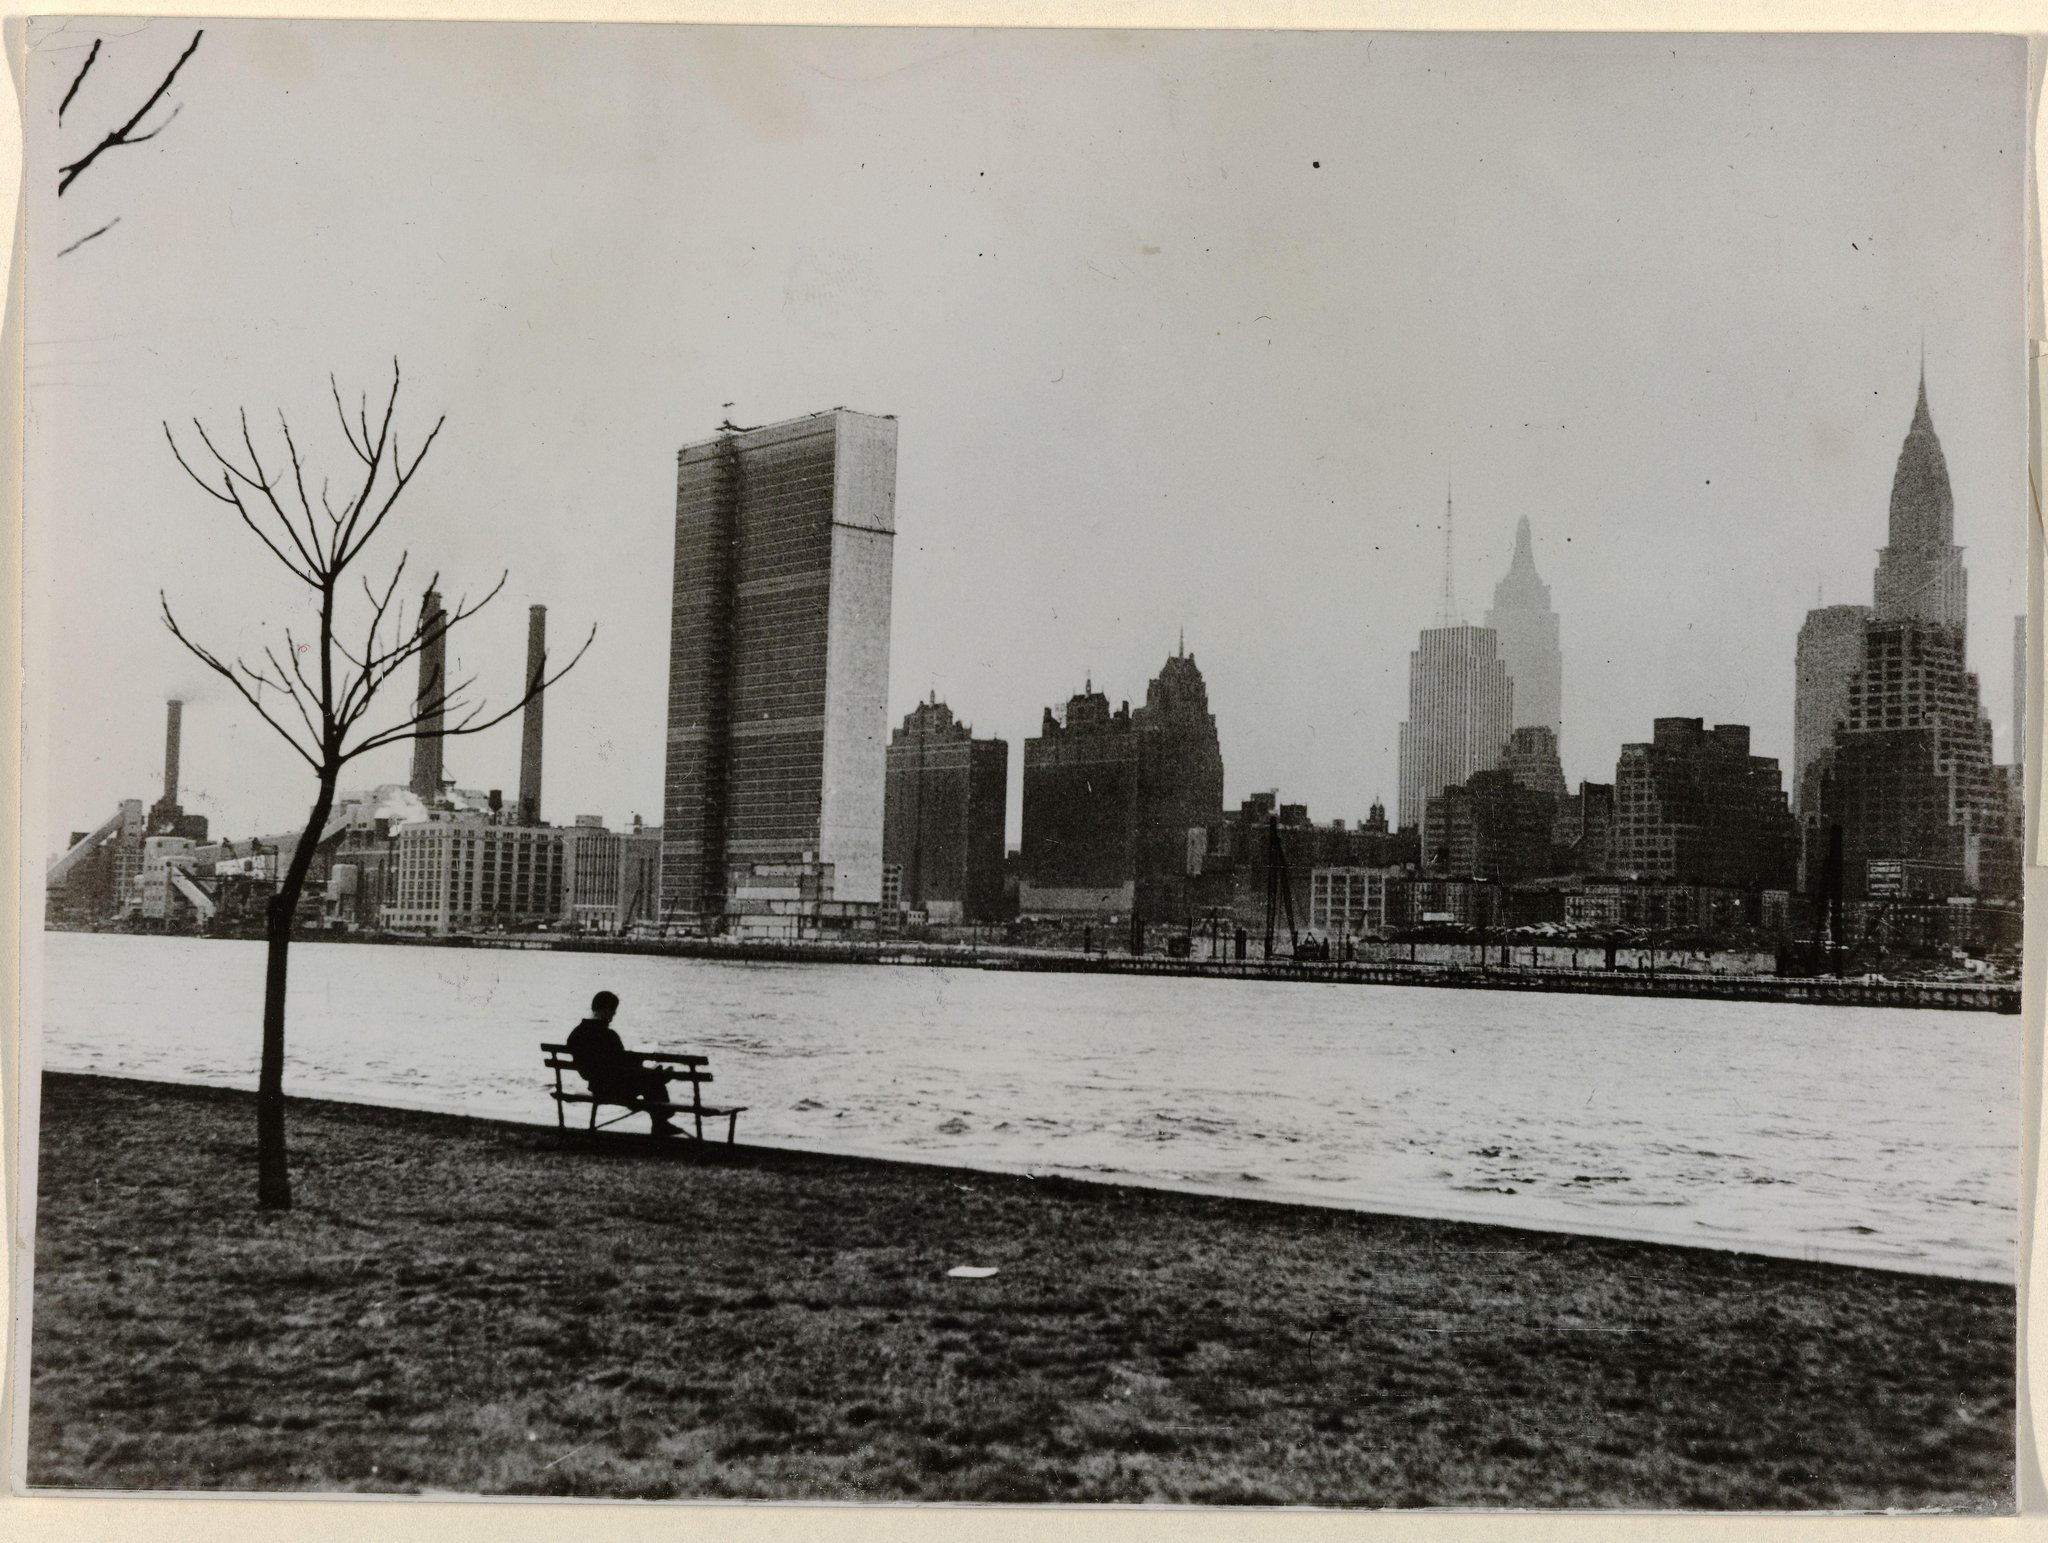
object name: photograph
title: Gezicht op het hoofdkwartier van de Verenigde Naties aan de East River in Manhattan, New York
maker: Anonymous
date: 1950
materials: paper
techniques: gelatin silver print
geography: london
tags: city-view in general; 'veduta', river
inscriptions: inscription: ‘KEYSTONE/ PRESS AGENCY LTD./ 4-7, RED LION COURT./ FLEET STREET LONDON, E.C.4.’, inscription: ‘A striking scene is presented by/ the almost completed United Nations building - on/ 42nd-st. and East River, looking across the East/ River, scaffolding can be seen on the back of the/ building (left - centre).. It will be the permanent/ home of the United nations./ JSS/KEYSTONE 1/537669’